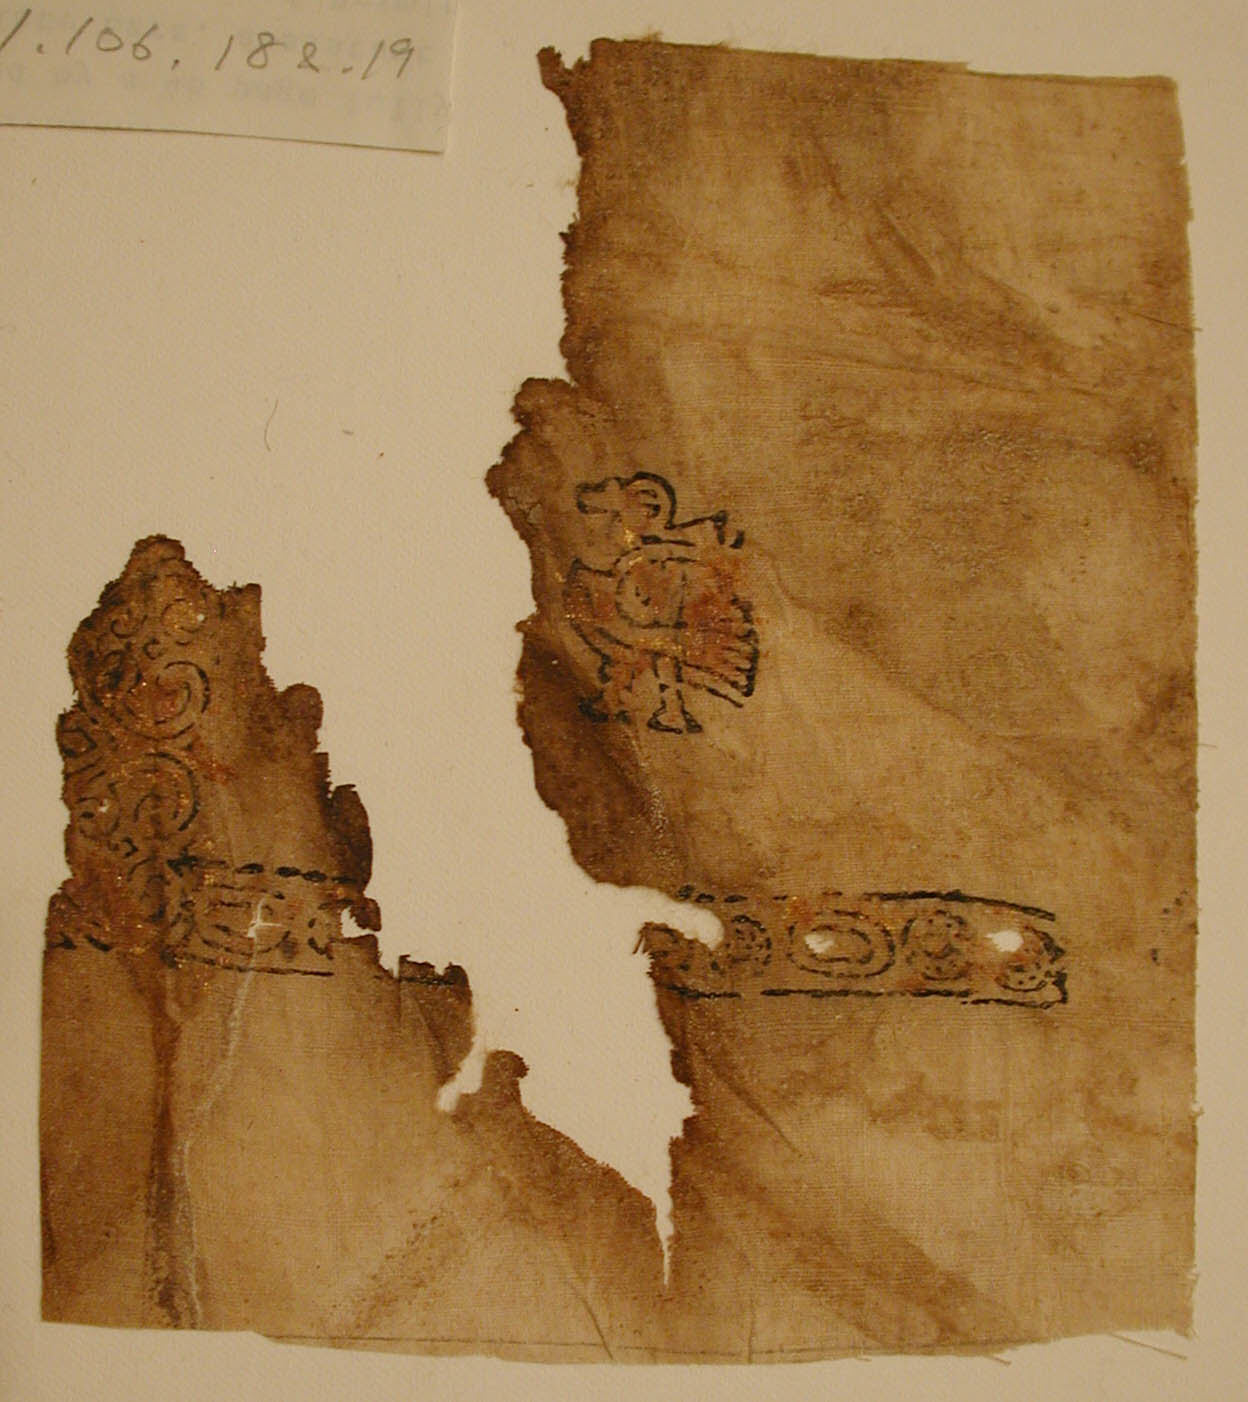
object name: textile fragment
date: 801-900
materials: linen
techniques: gilding, stamping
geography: egypt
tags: birds